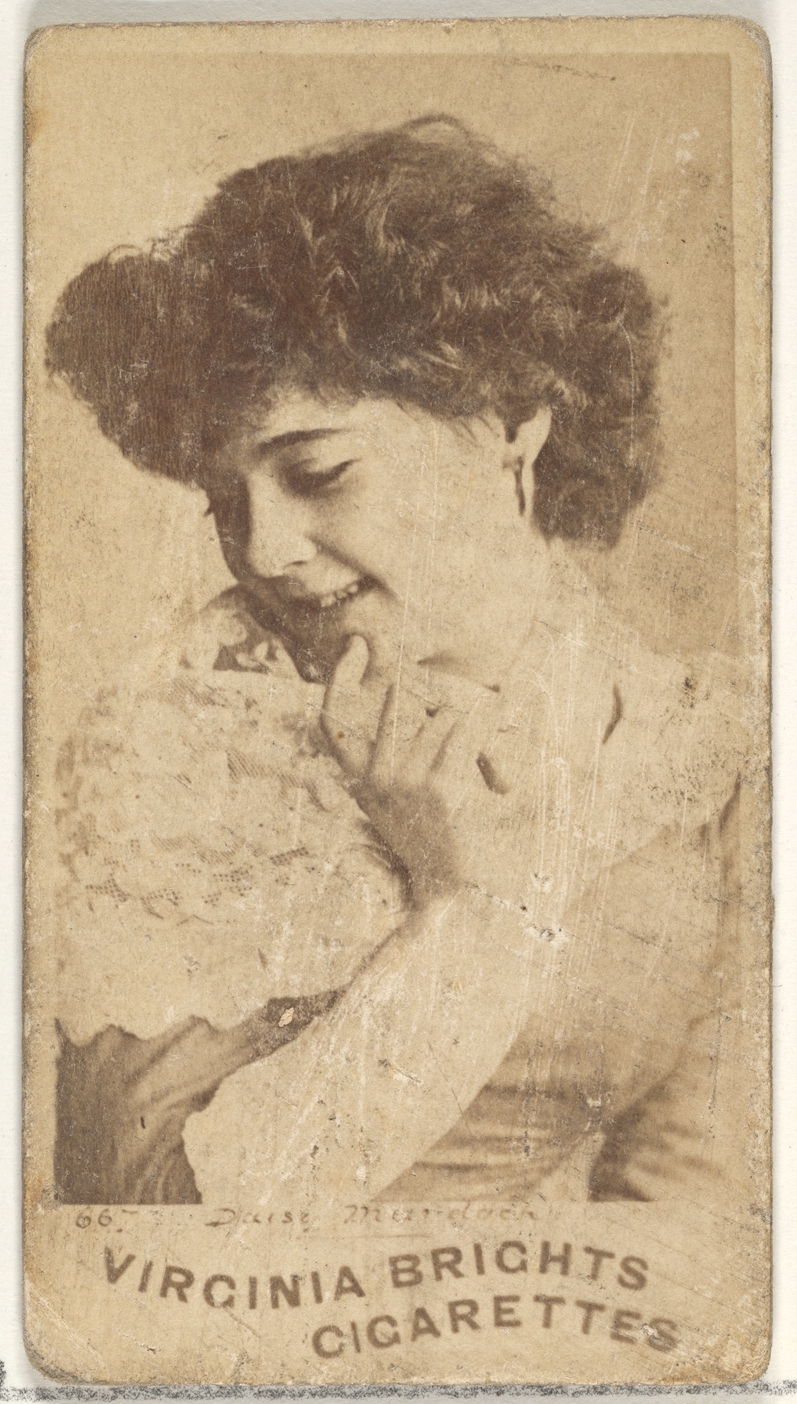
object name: photograph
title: Card 667, Daisy Murdoch, from the Actors and Actresses series (N45, Type 1) for Virginia Brights Cigarettes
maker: allen & ginter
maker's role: publisher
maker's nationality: american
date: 1888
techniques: albumen silver print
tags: girls,portraits,actresses